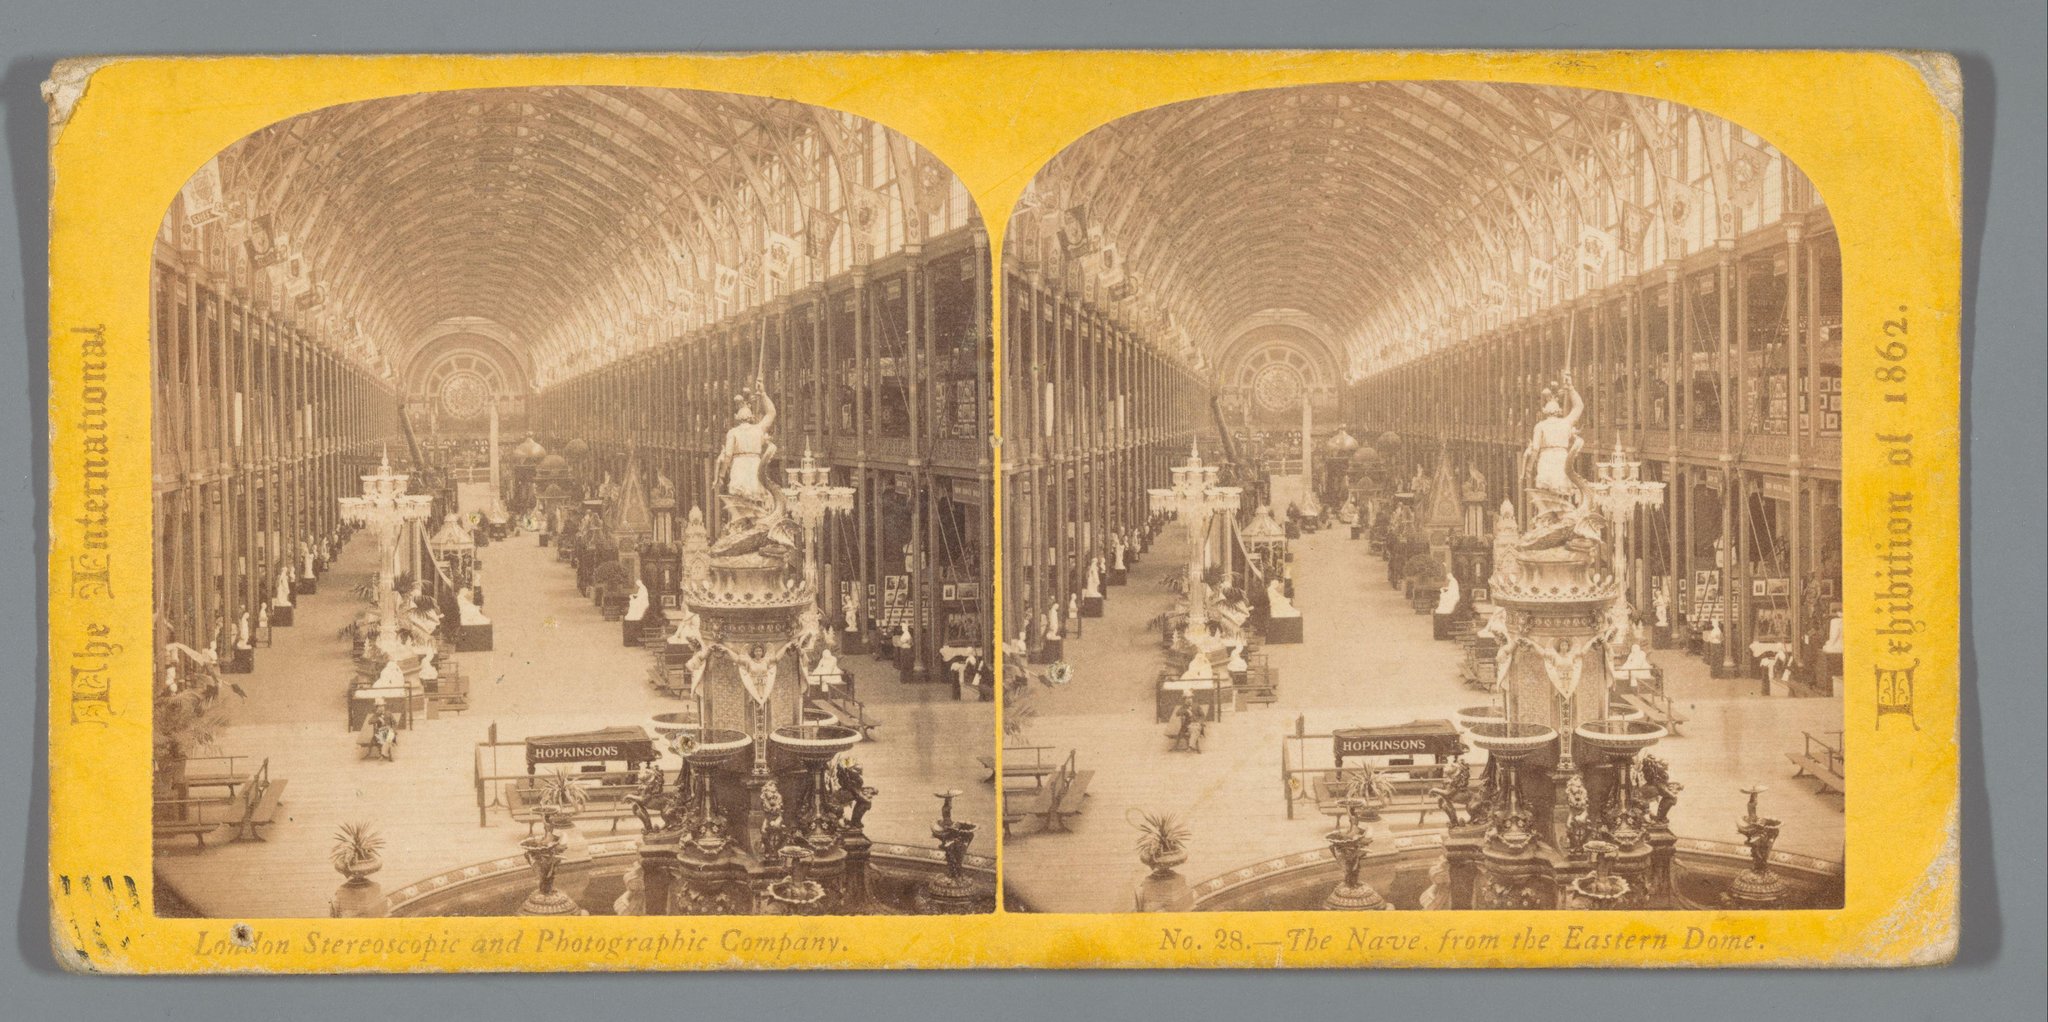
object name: stereograph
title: Interieur van het Palace of Art and Industry op de Wereldtentoonstelling van 1862, gezien vanaf de oostzijde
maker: william england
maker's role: fotograaf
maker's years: 1816-1896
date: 1862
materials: cardboard, paper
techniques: albumen print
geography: london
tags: world fair, world exhibition, interior of industrial structures (regardless of the materials processed or the products made, london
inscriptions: number: ‘No. 28.’